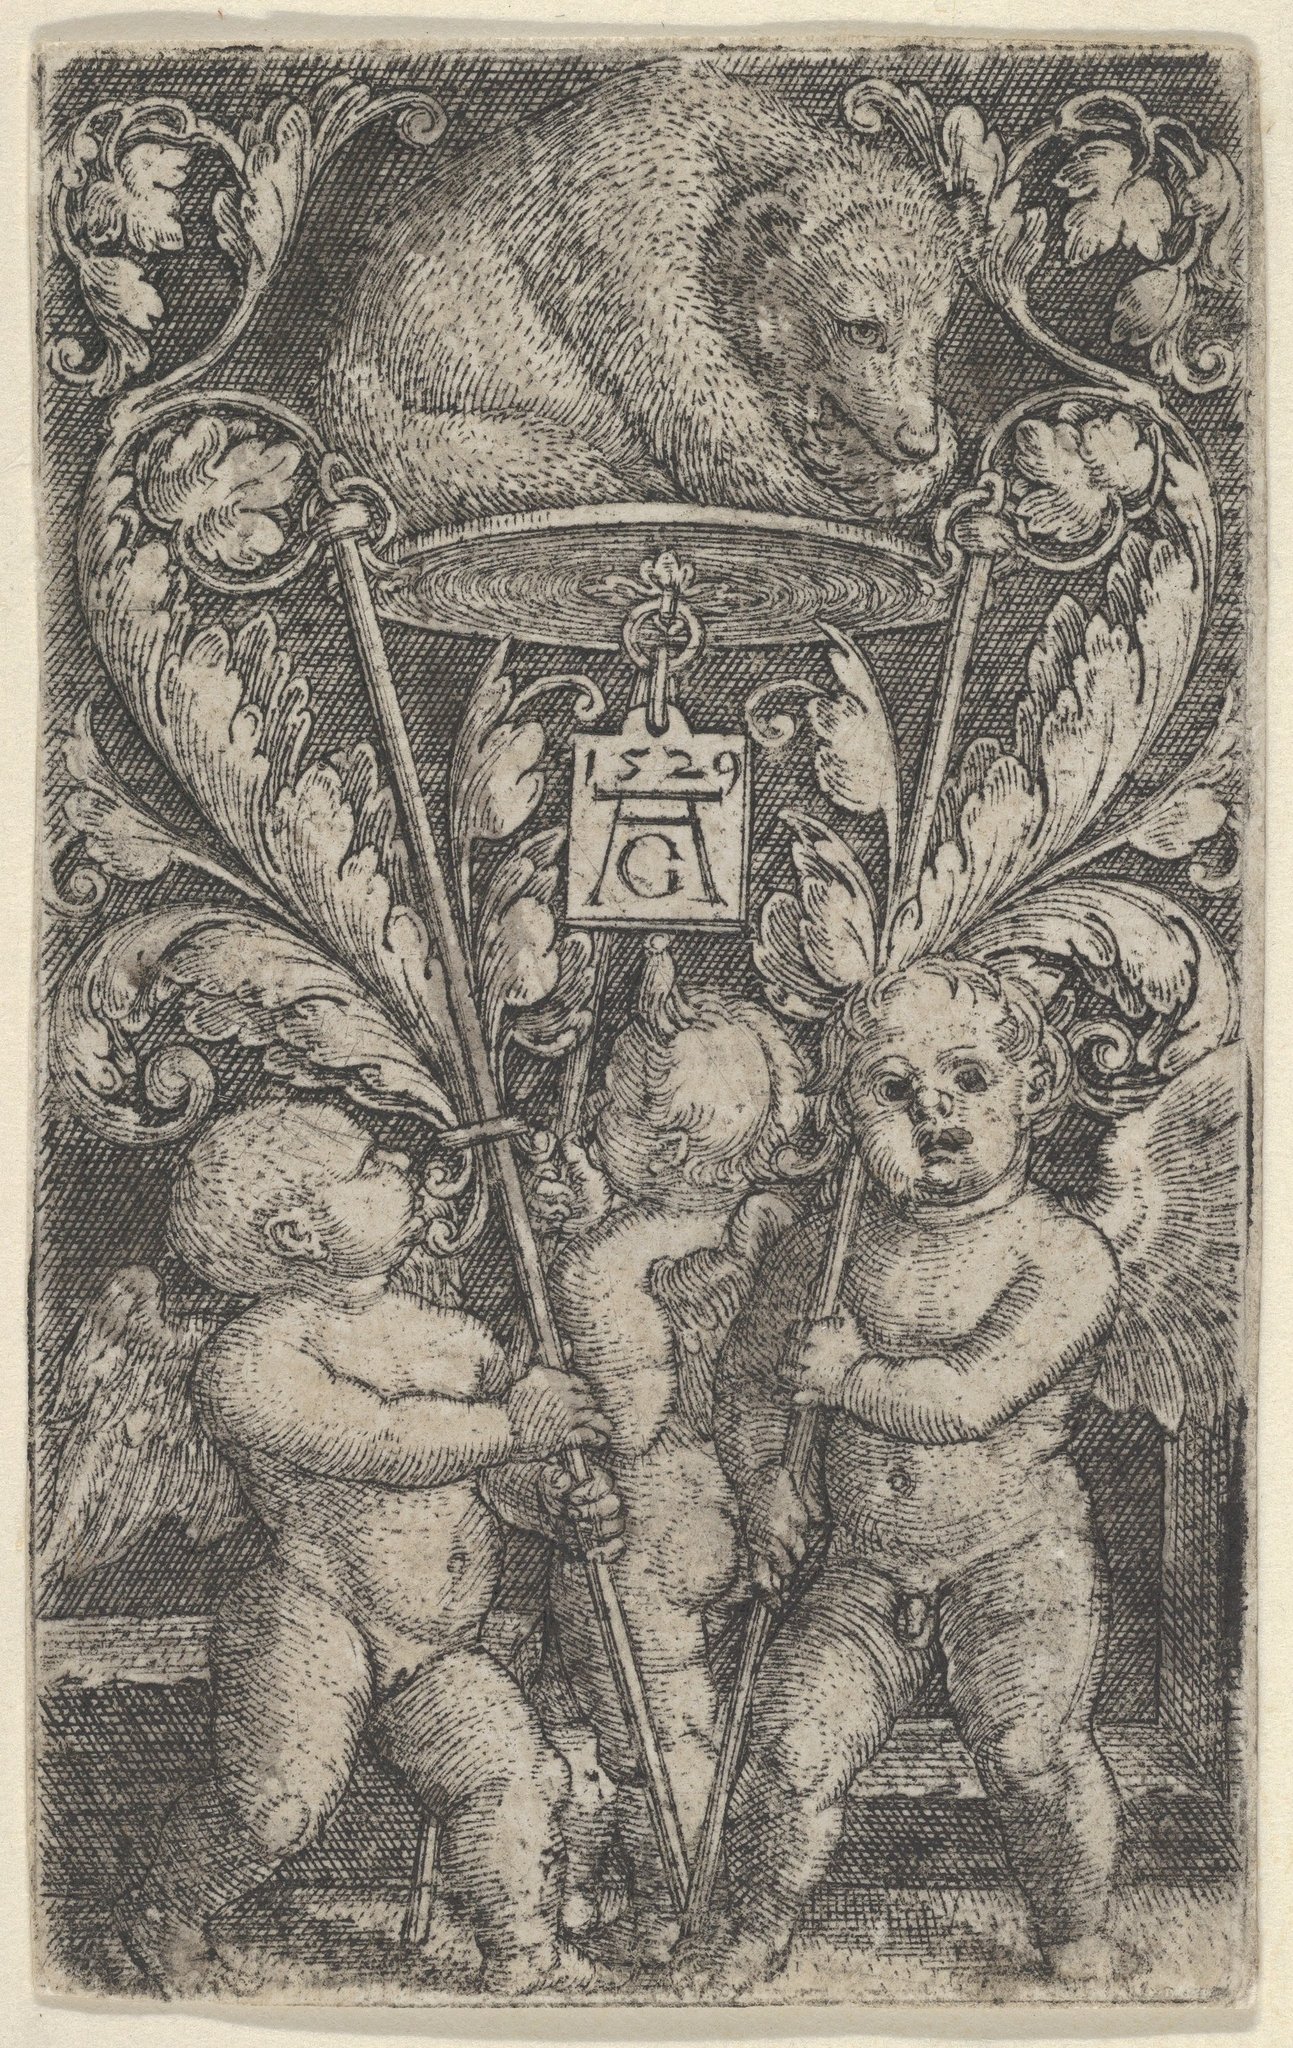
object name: print ornament architecture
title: Vertical Panel with Three Winged Boys Carrying a Bear on a Tray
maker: heinrich aldegrever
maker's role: artist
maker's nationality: german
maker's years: 1502-1561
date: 1529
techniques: engraving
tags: bears,putti